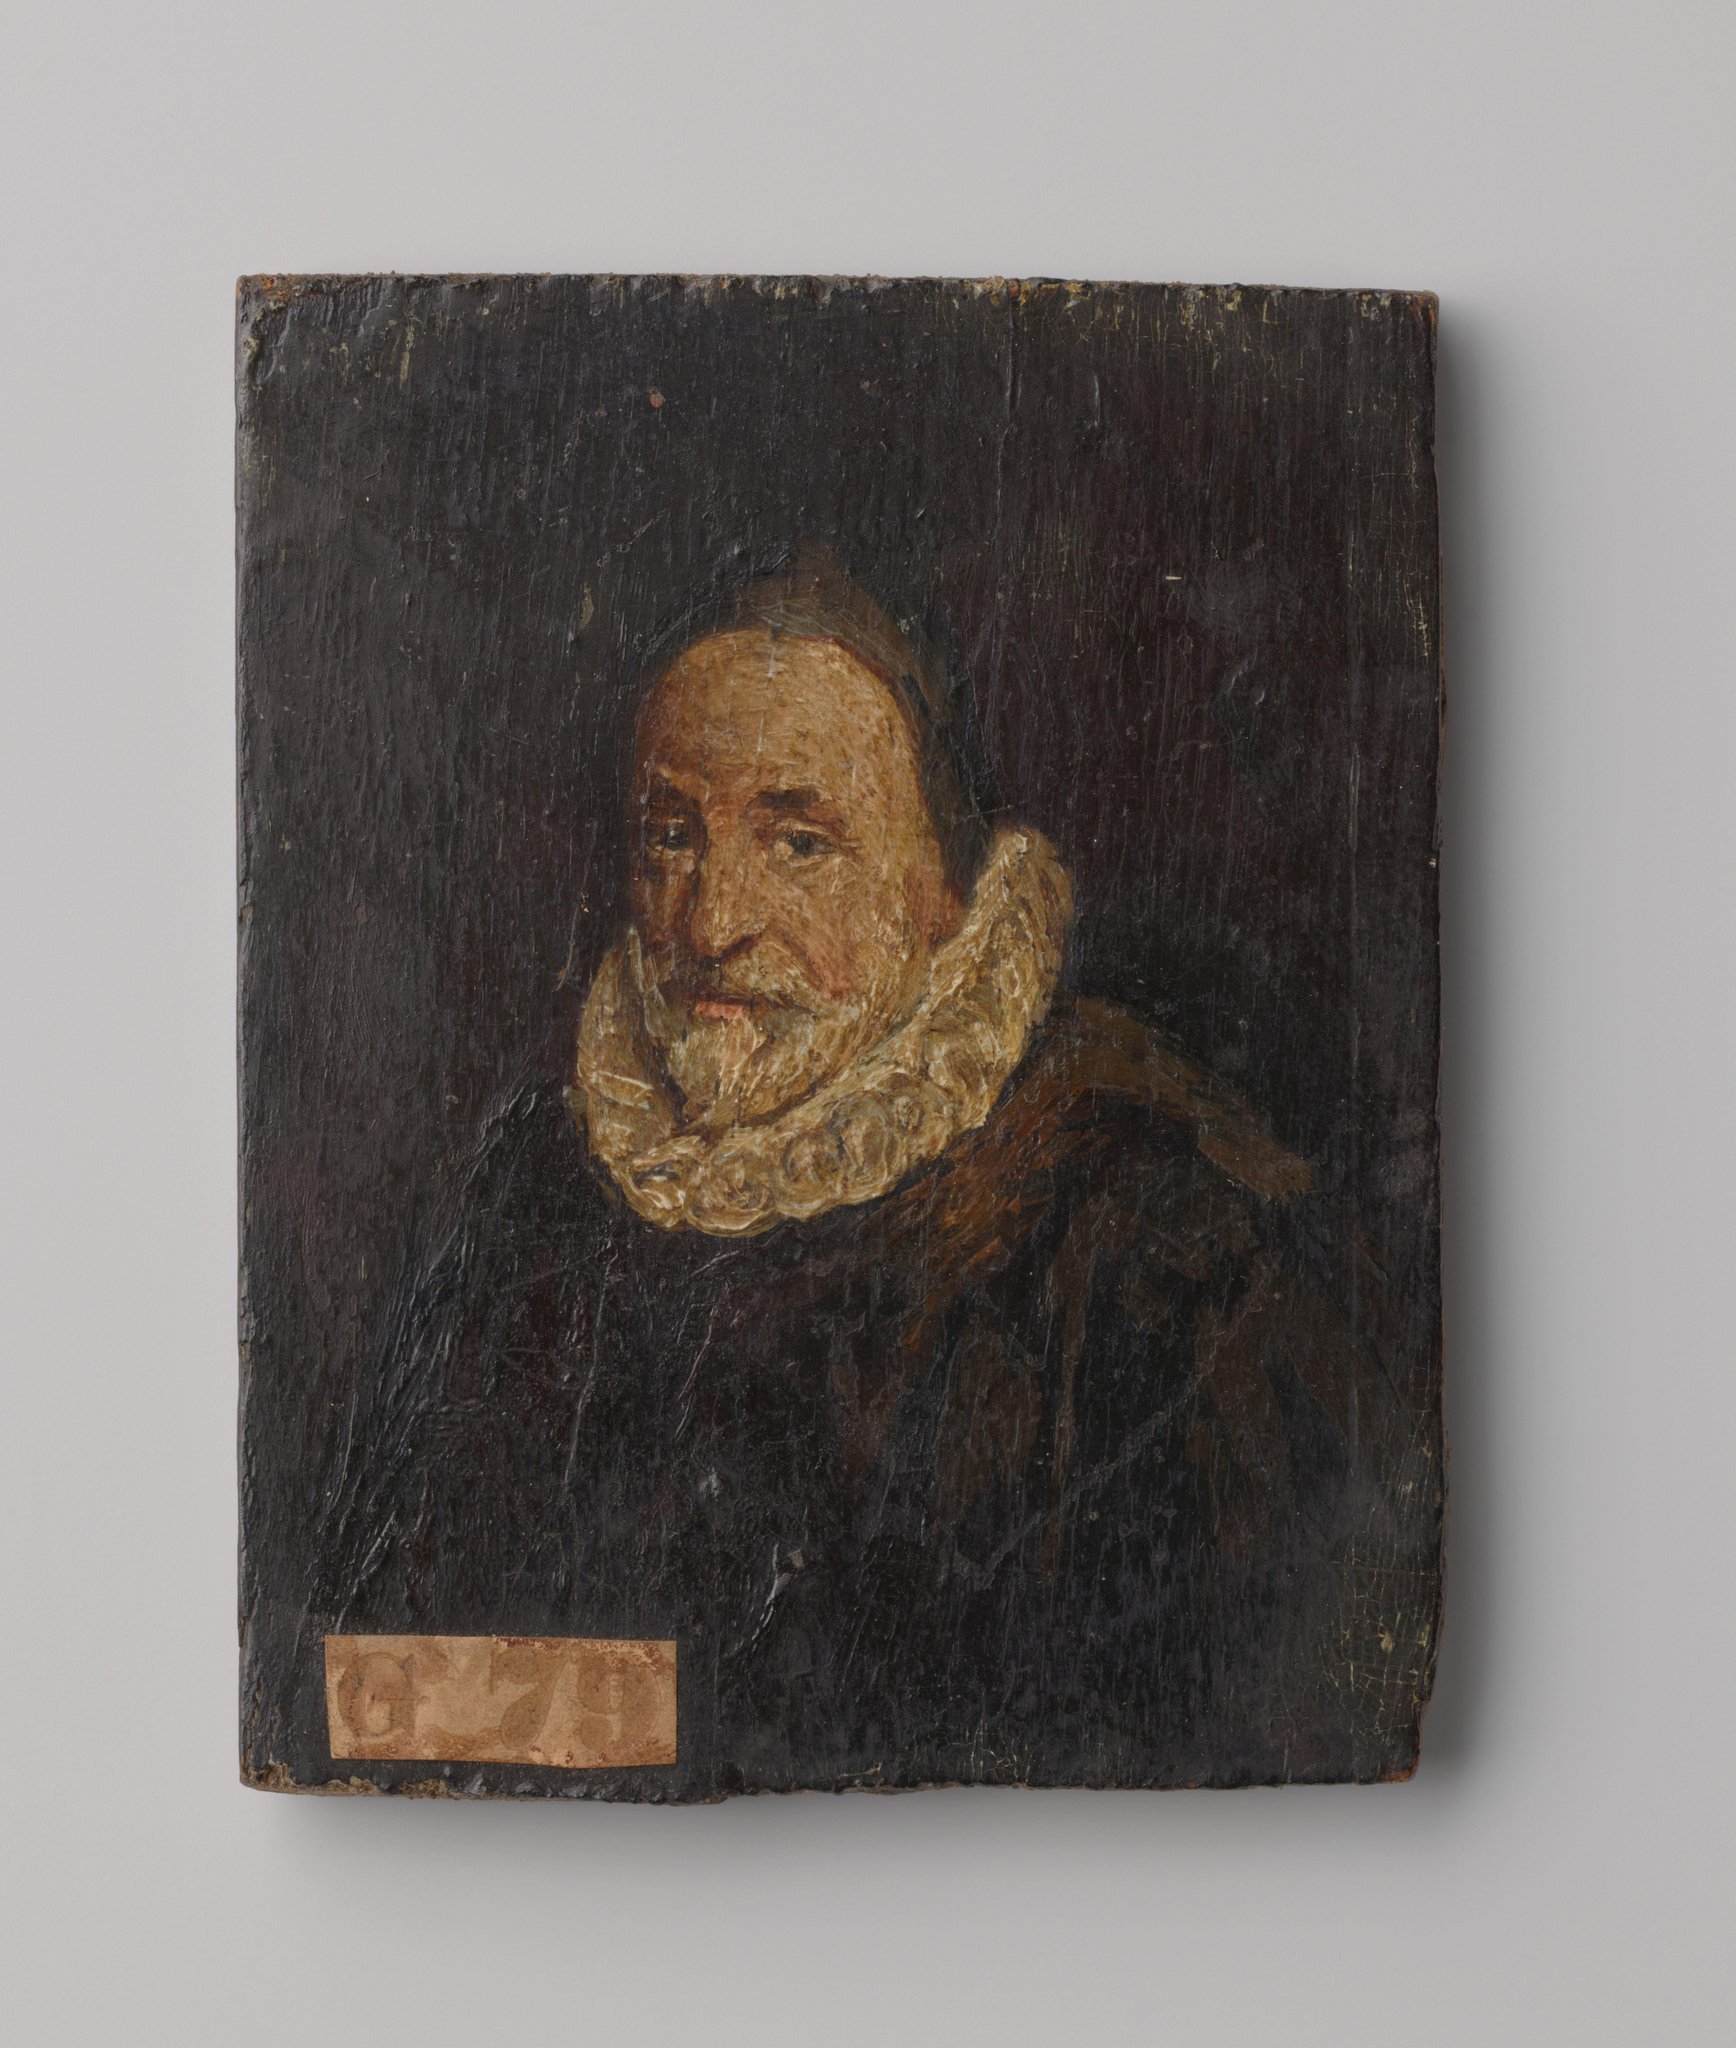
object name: painting, miniature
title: Portretminiatuur van Cornelis Pietersz Hooft (1546-1626)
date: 1400-1950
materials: paint, wood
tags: amsterdam, the hague, pieter corneliszoon hooft